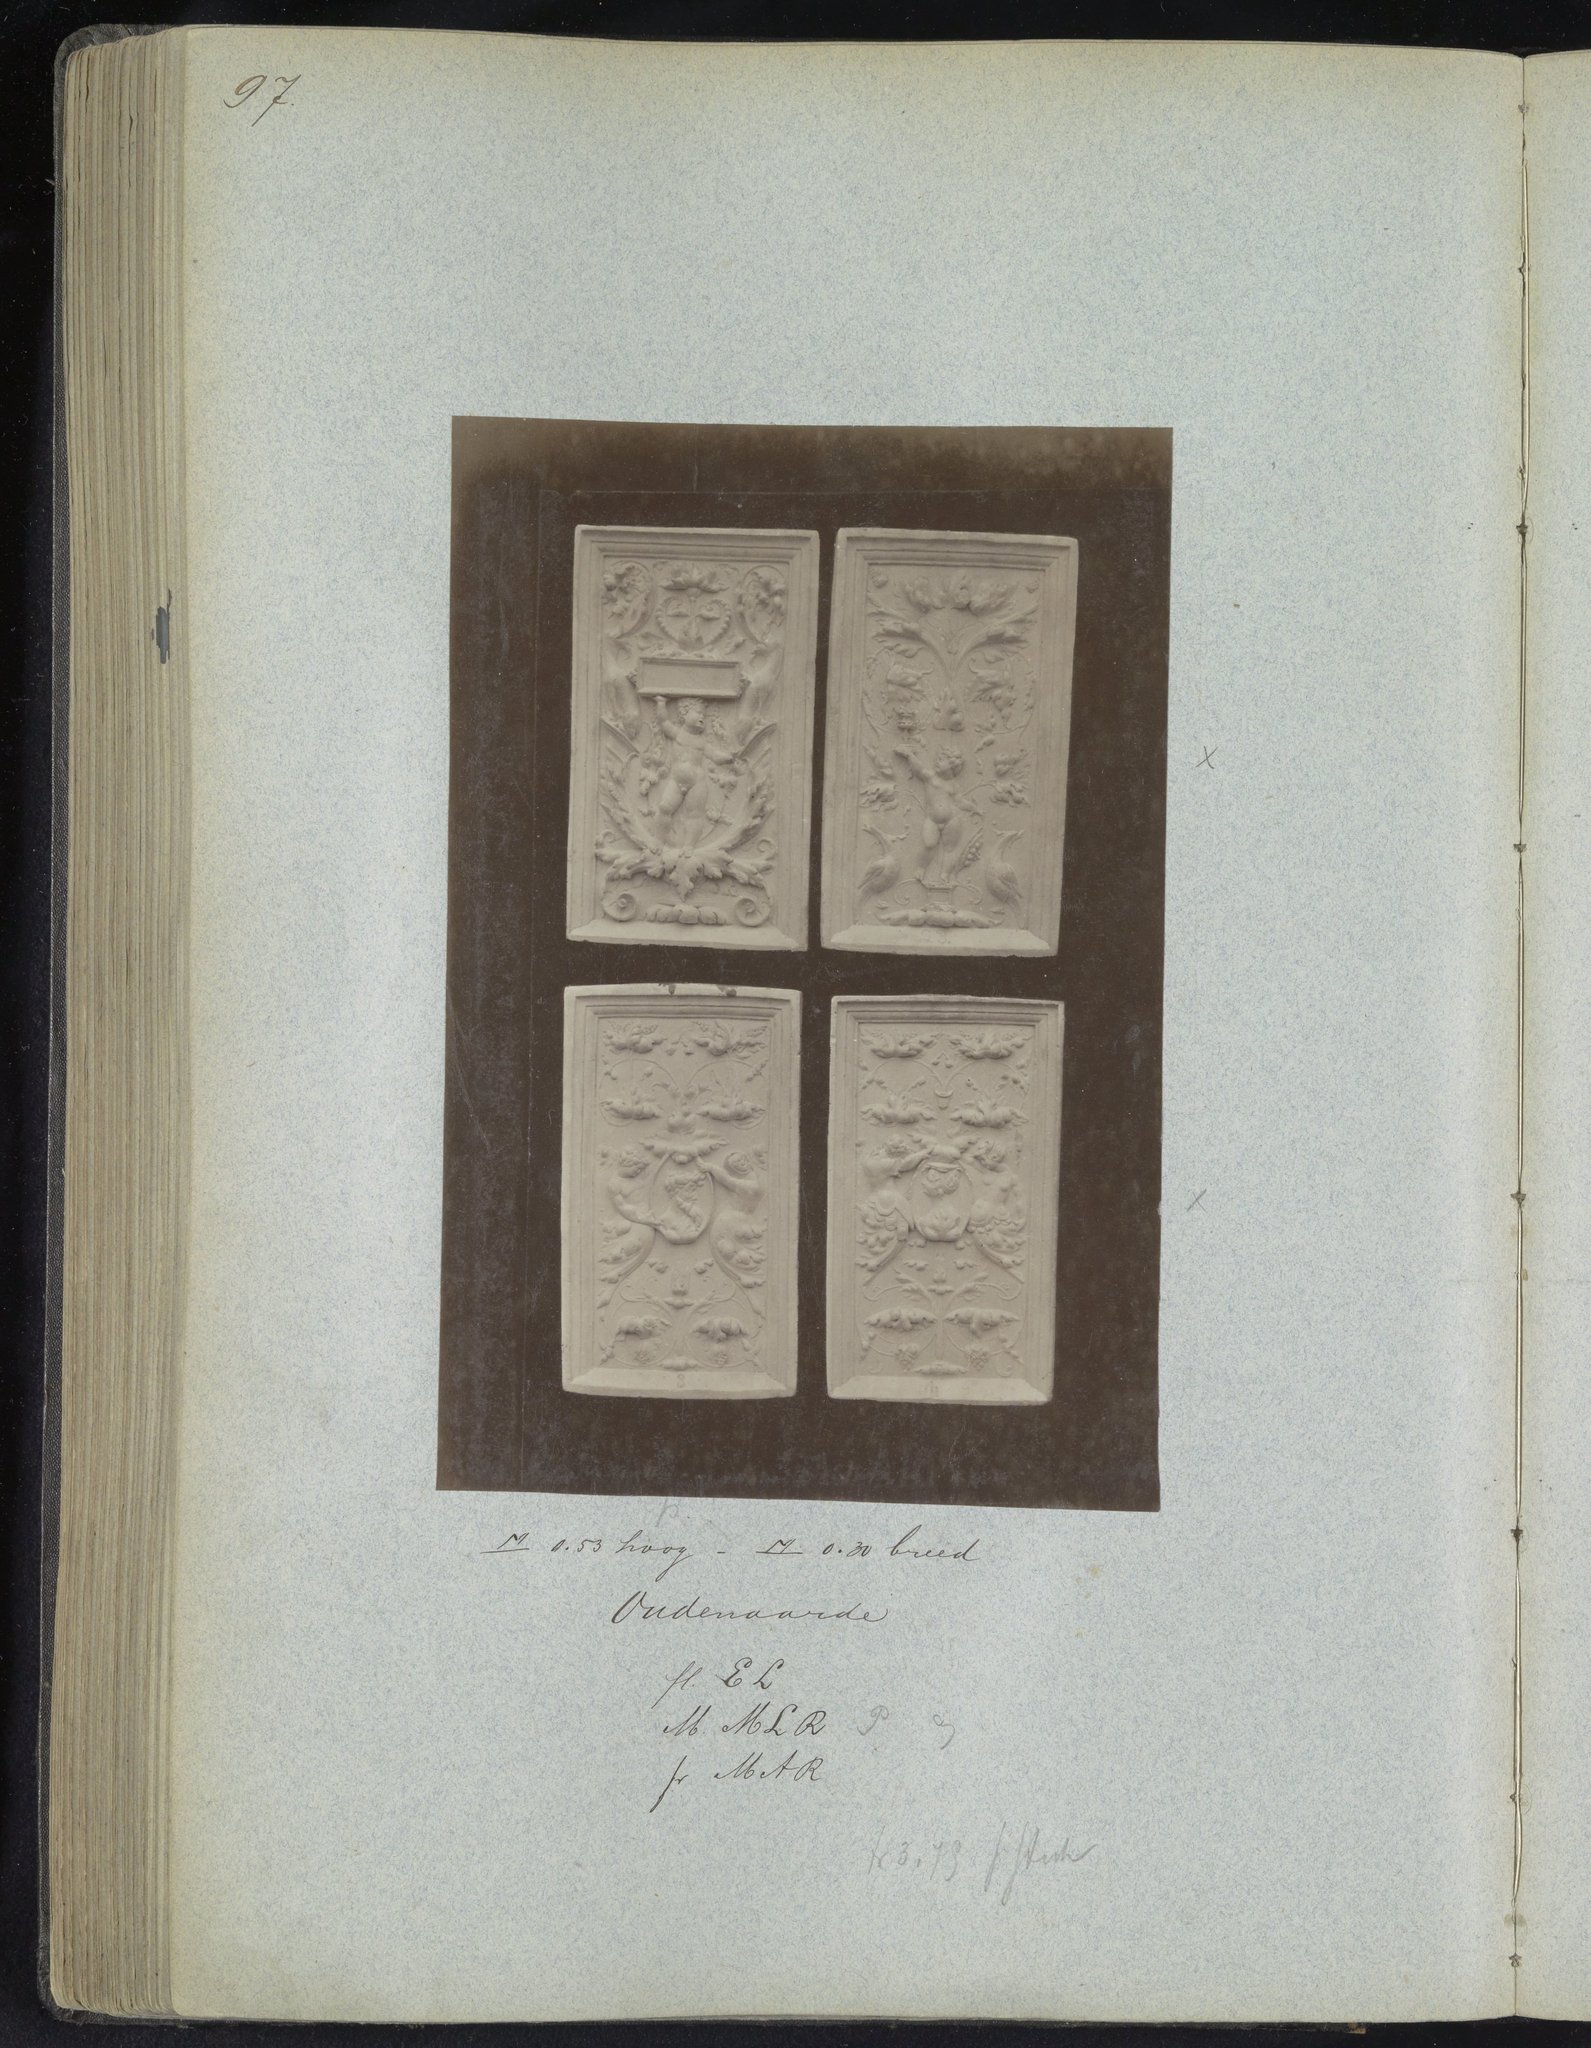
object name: photograph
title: Vier gipsen afgietsels van panelen, vermoedelijk afkomstig uit Oudenaarde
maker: Anonymous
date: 1875-1900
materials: paper, photographic support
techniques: albumen print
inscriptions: annotation: ‘M 0.53 hoog - M 0.30 breed’, annotation: ‘Oudenaarde’, annotation